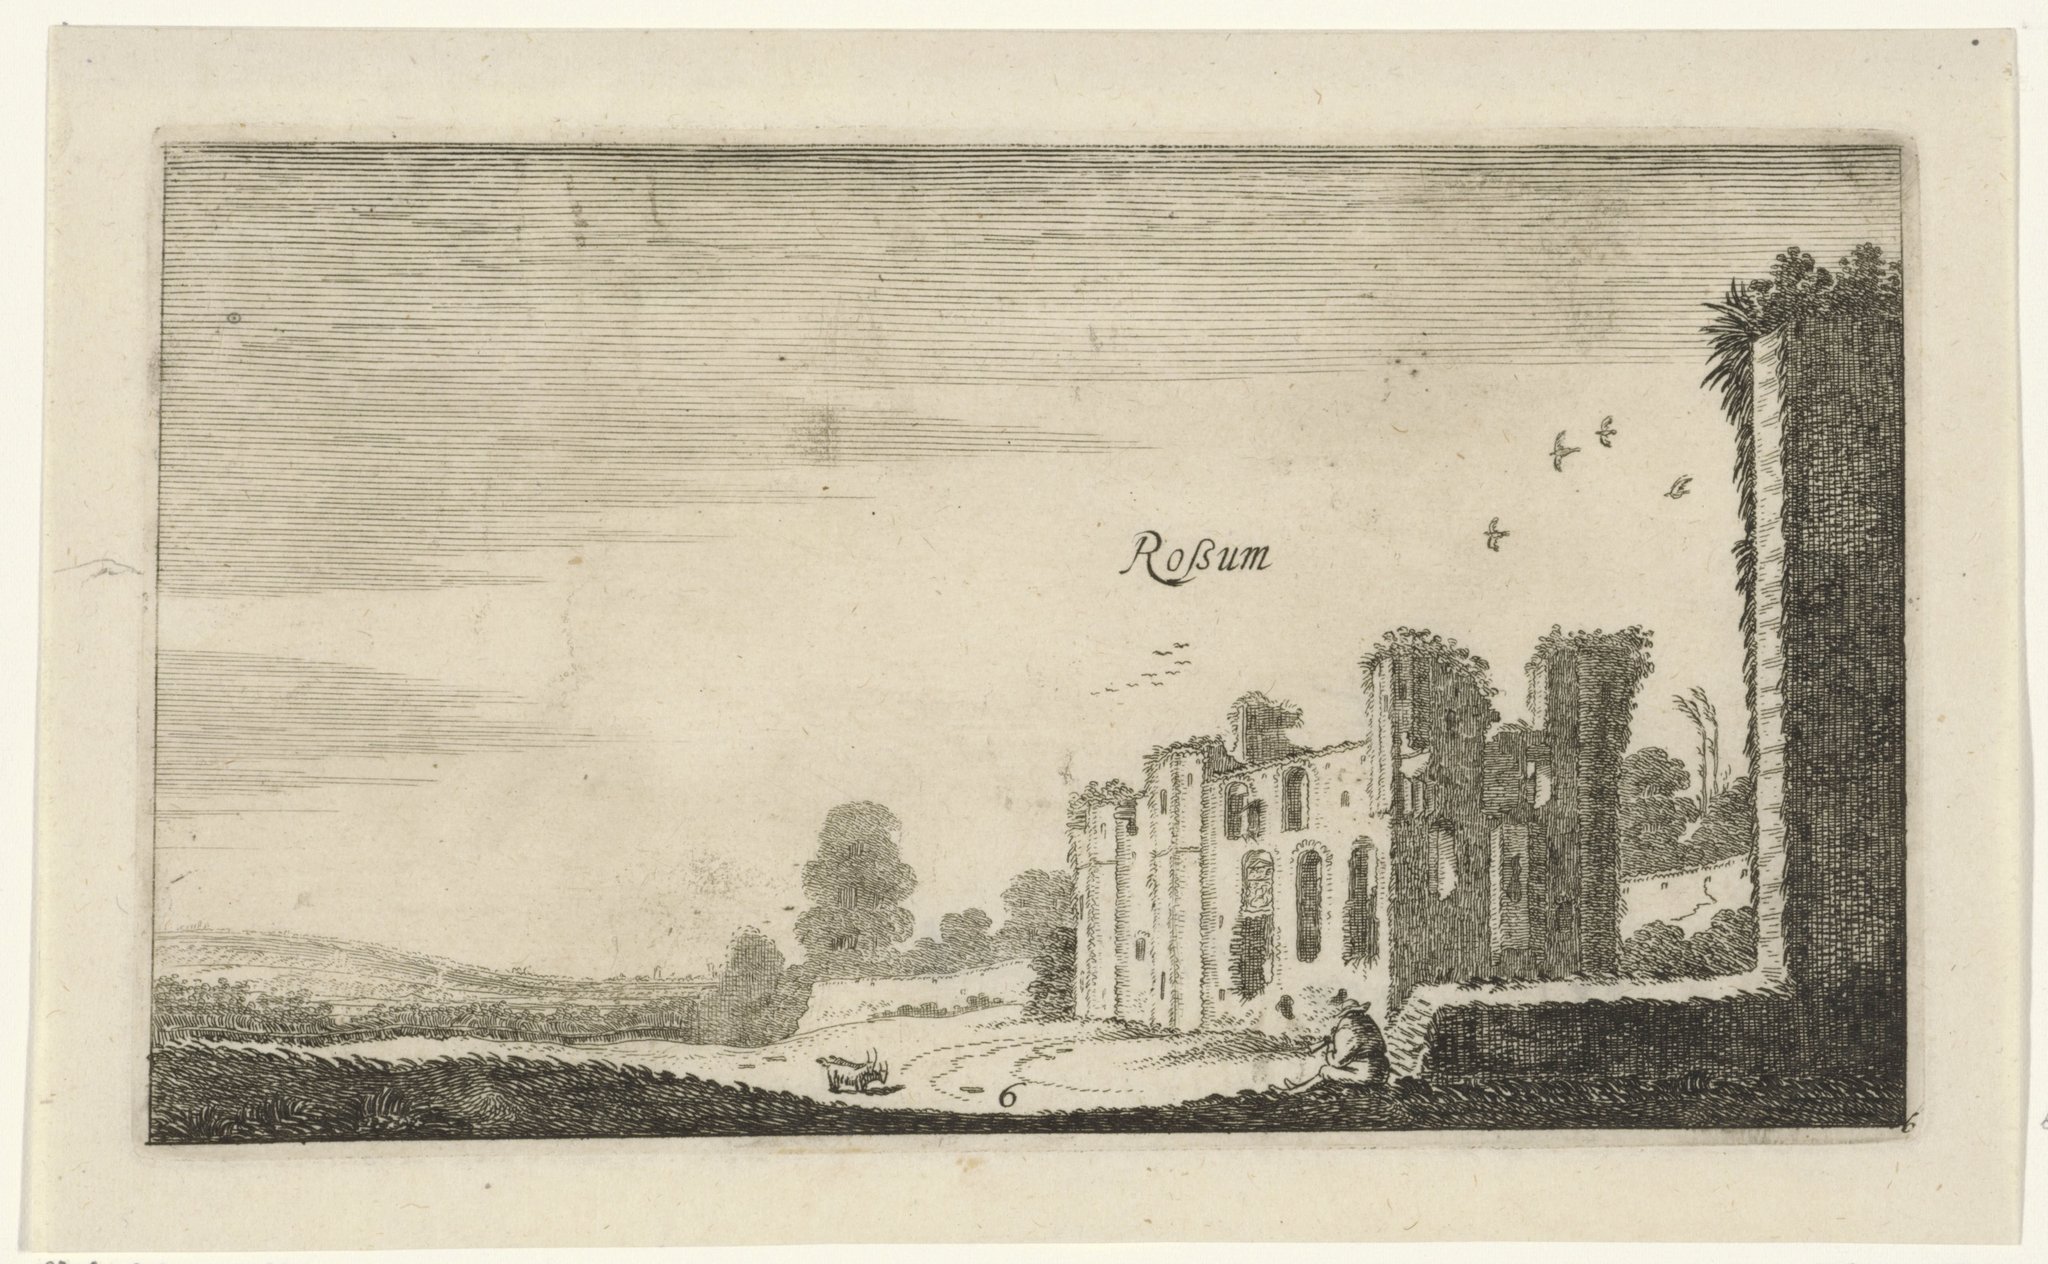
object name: print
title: Kastelen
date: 1616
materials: paper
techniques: etching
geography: northern netherlands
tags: landscape with ruins, landscape with tower or castle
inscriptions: collector's mark: Lugt 964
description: Ruïne van het kasteel Rossum. Op de voorgrond een zittende figuur. Zesde prent uit een serie van zes.